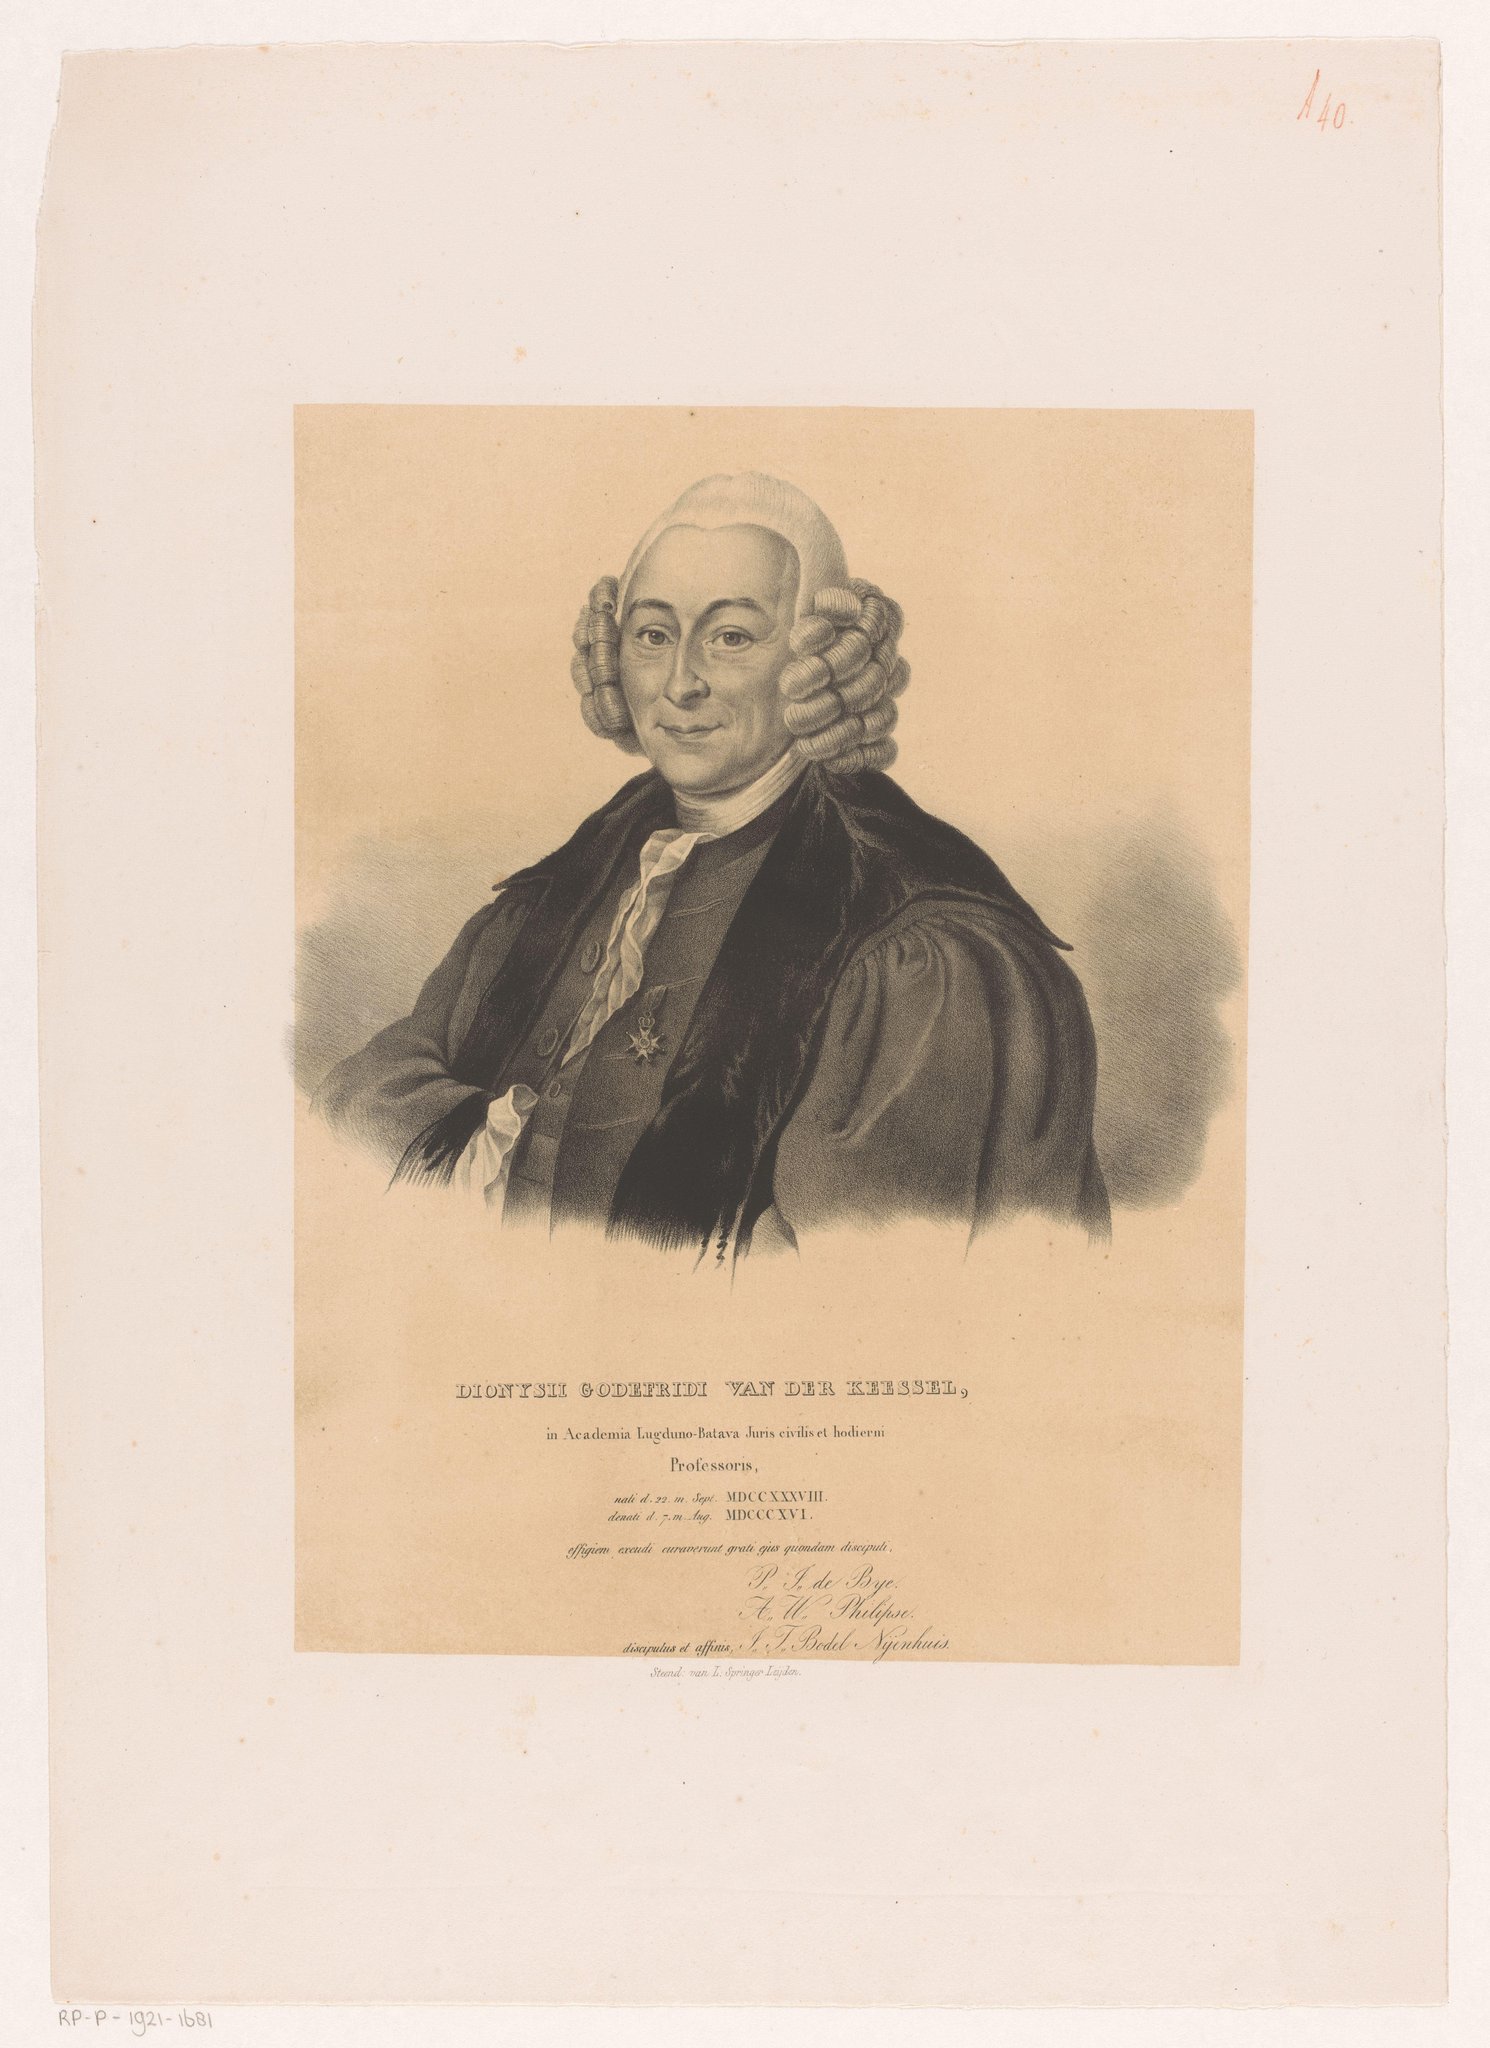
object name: print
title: Portret van Dionysius Godefridus van der Keessel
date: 1816-1871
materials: paper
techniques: tone lithography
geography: leiden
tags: deventer, historical persons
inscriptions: collector's mark: Lugt 2233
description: Onder het portret de biografische gegevens van de geportretteerde en de namen van drie van zijn leerlingen die dit portret na zijn dood lieten maken.